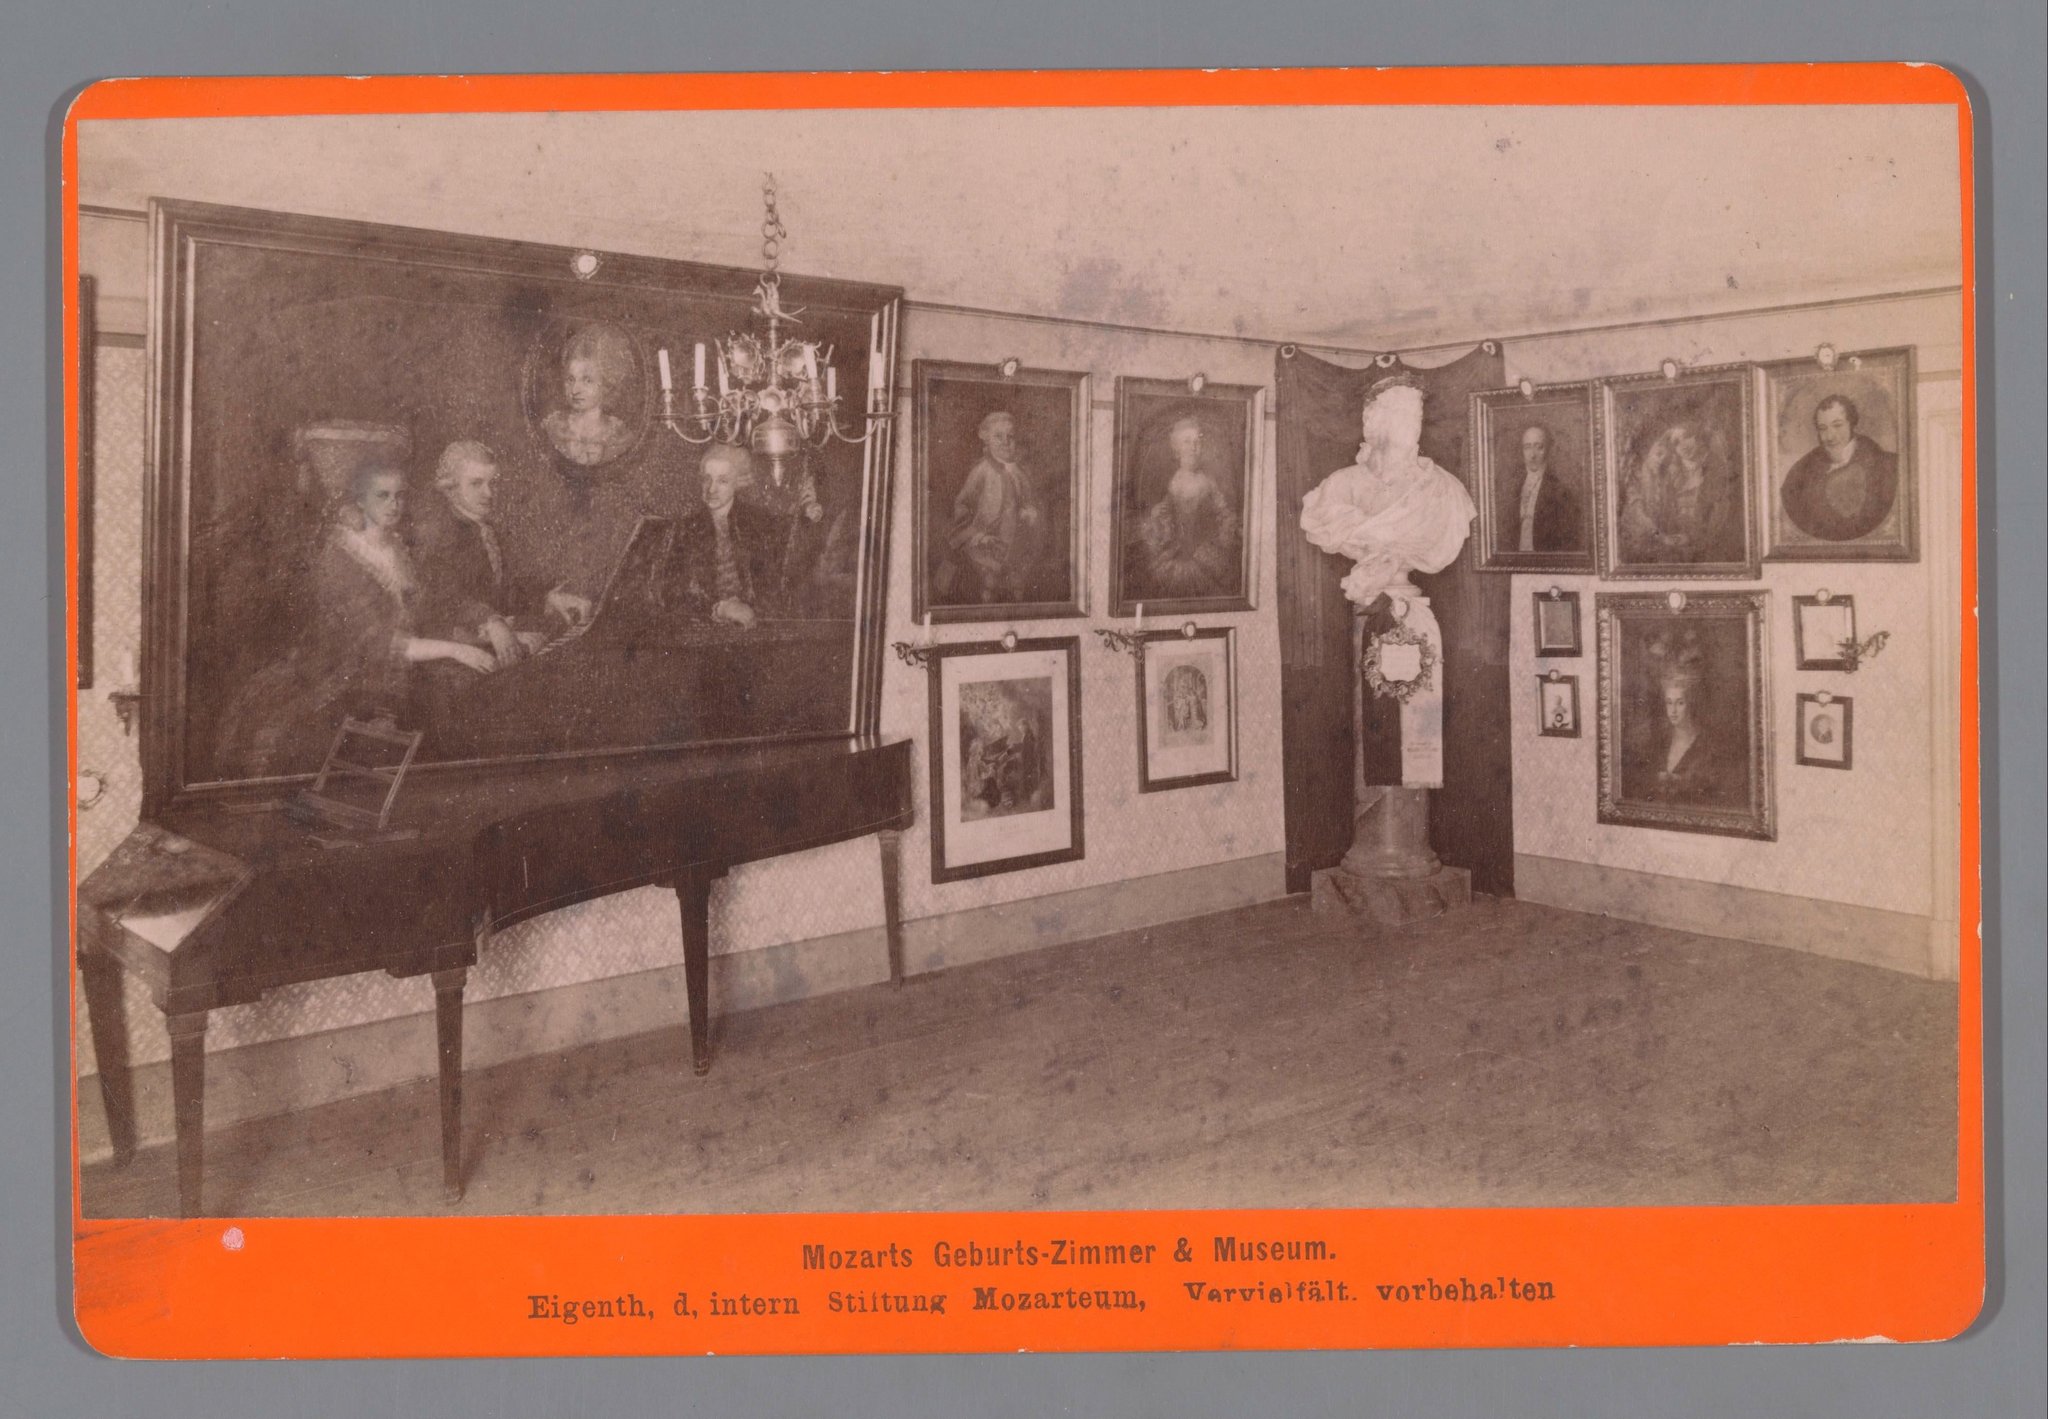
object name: photograph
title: Mozarts Geburts-Zimmer & Museum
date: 1870-1890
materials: cardboard, photographic support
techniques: albumen print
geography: salzburg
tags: vienna, permanent exhibition, museum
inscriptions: inscription: ‘Eigenth, d, intern Stiftung Mozarteum, Vervielfält. vorbehalten’